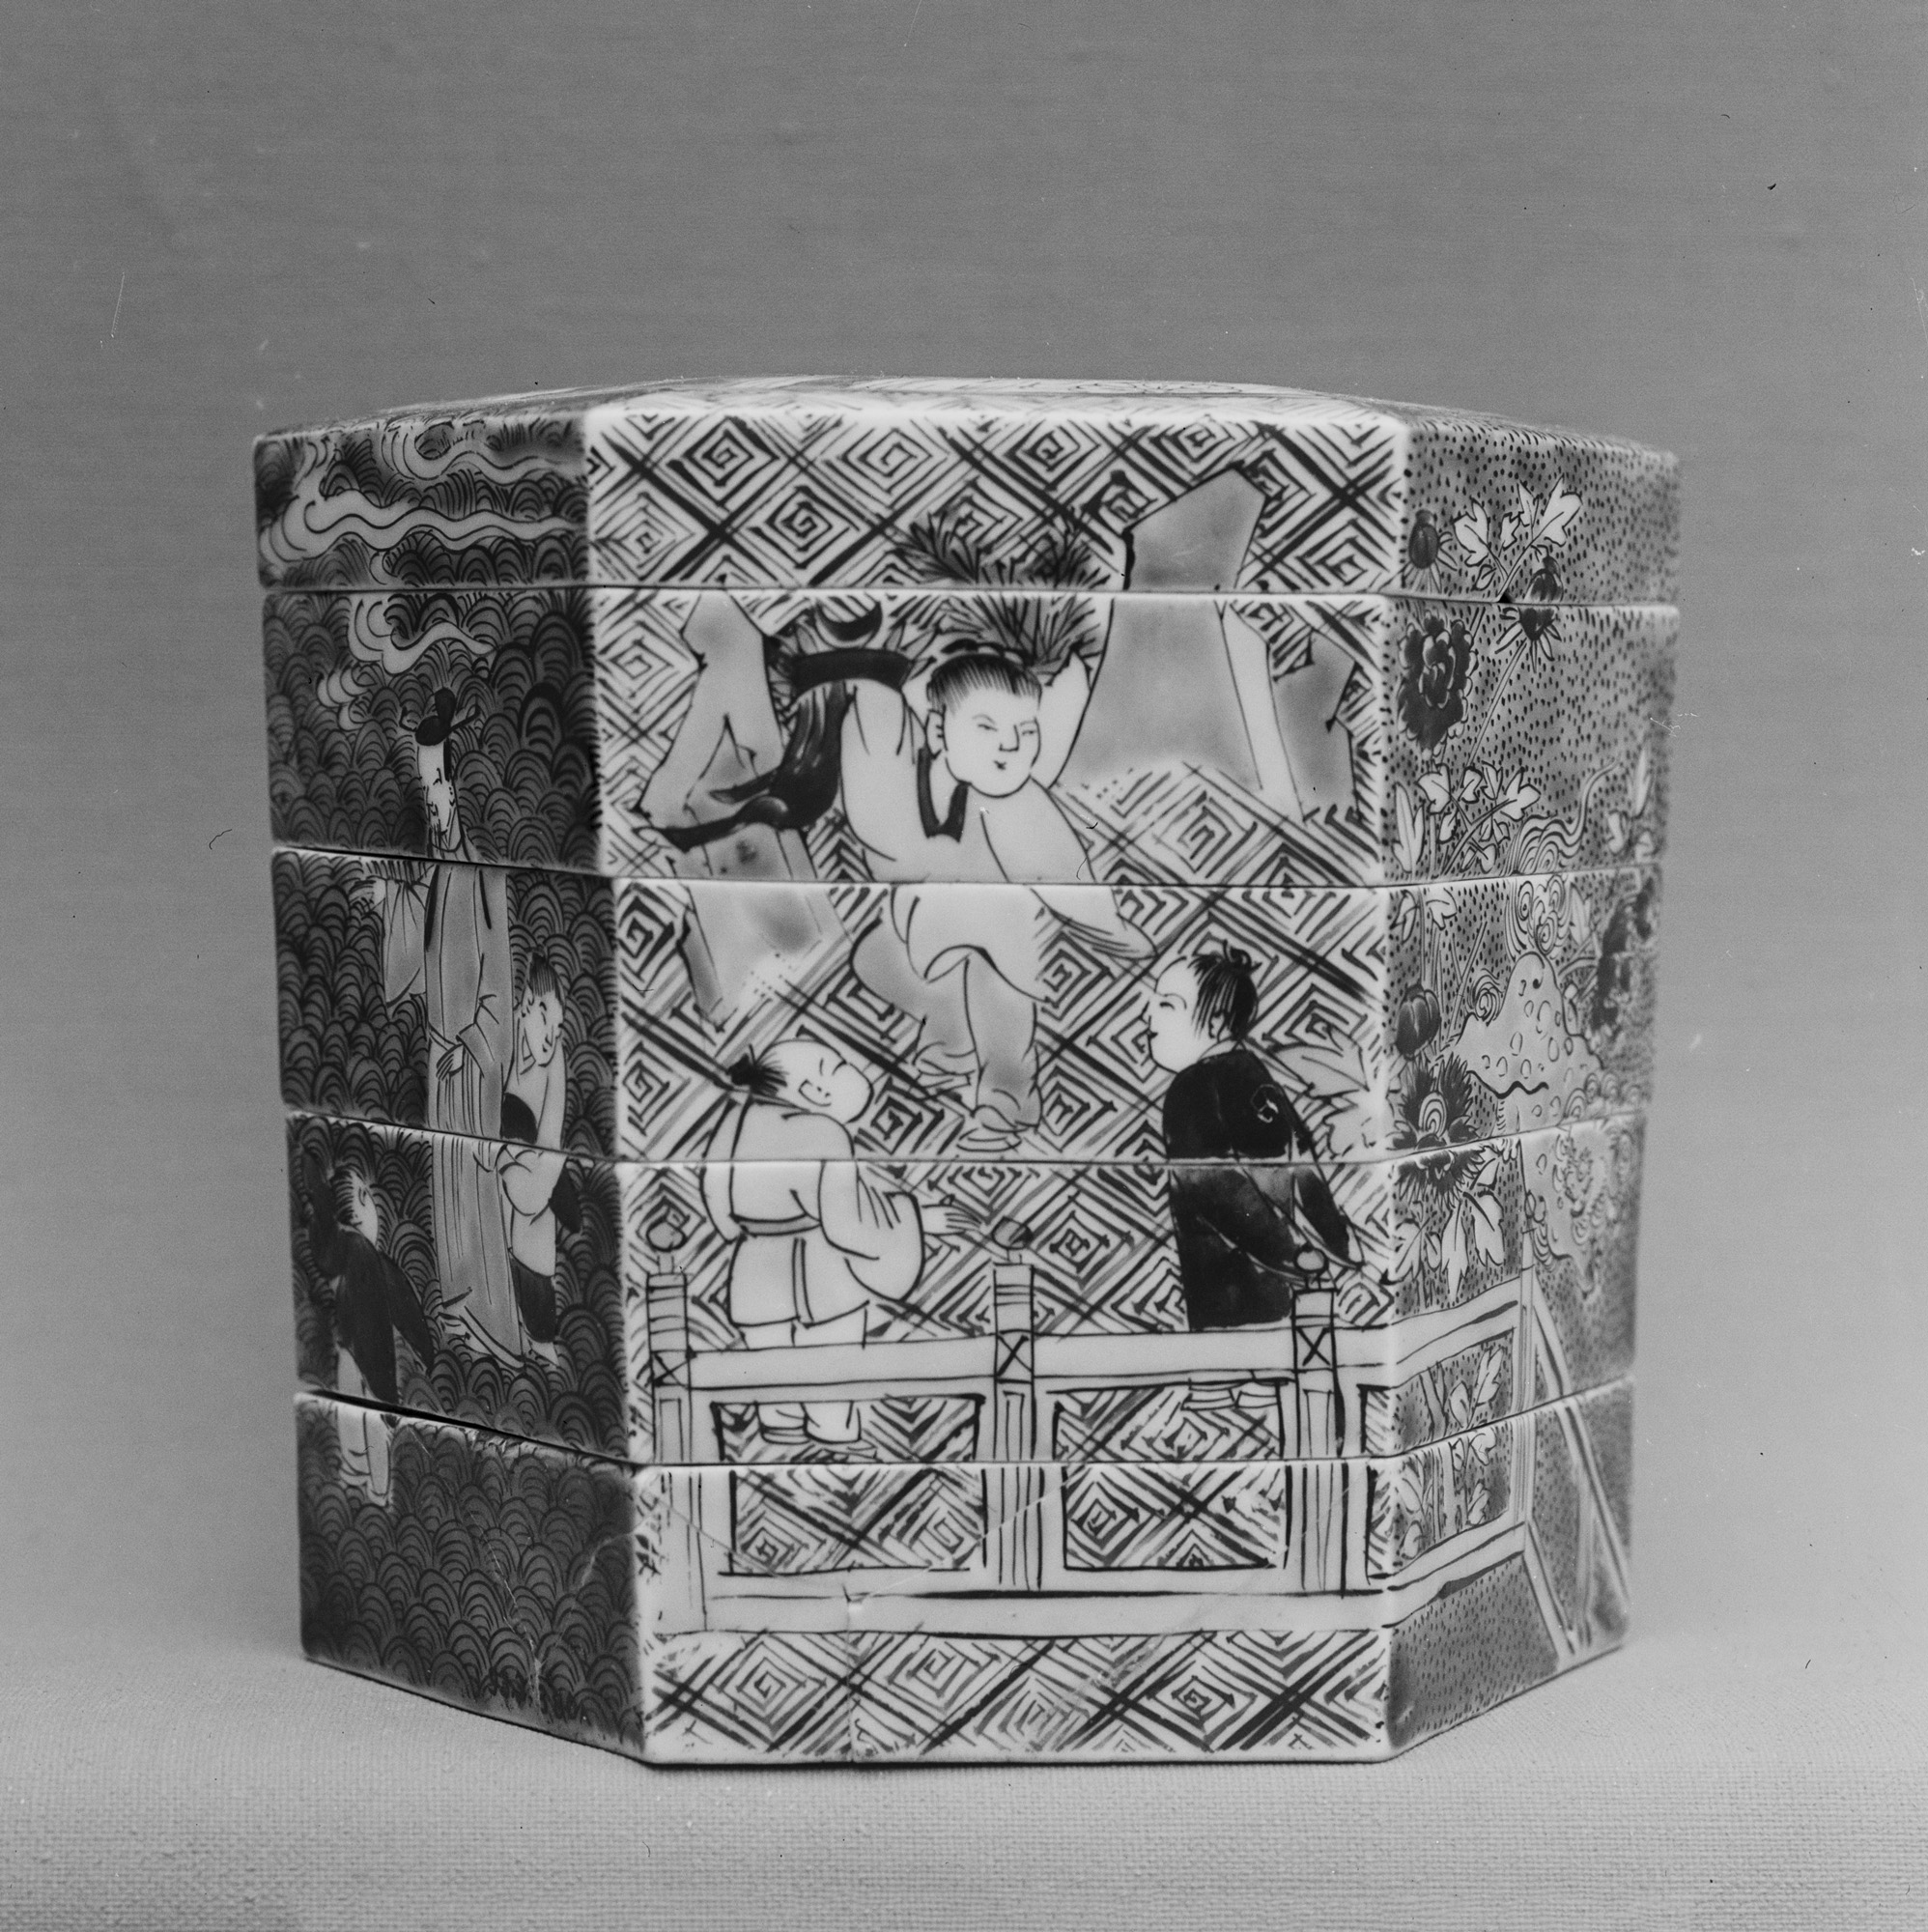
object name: box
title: Box in Five Compartments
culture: japanese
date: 1730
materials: enamel, porcelain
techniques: polychrome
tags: men